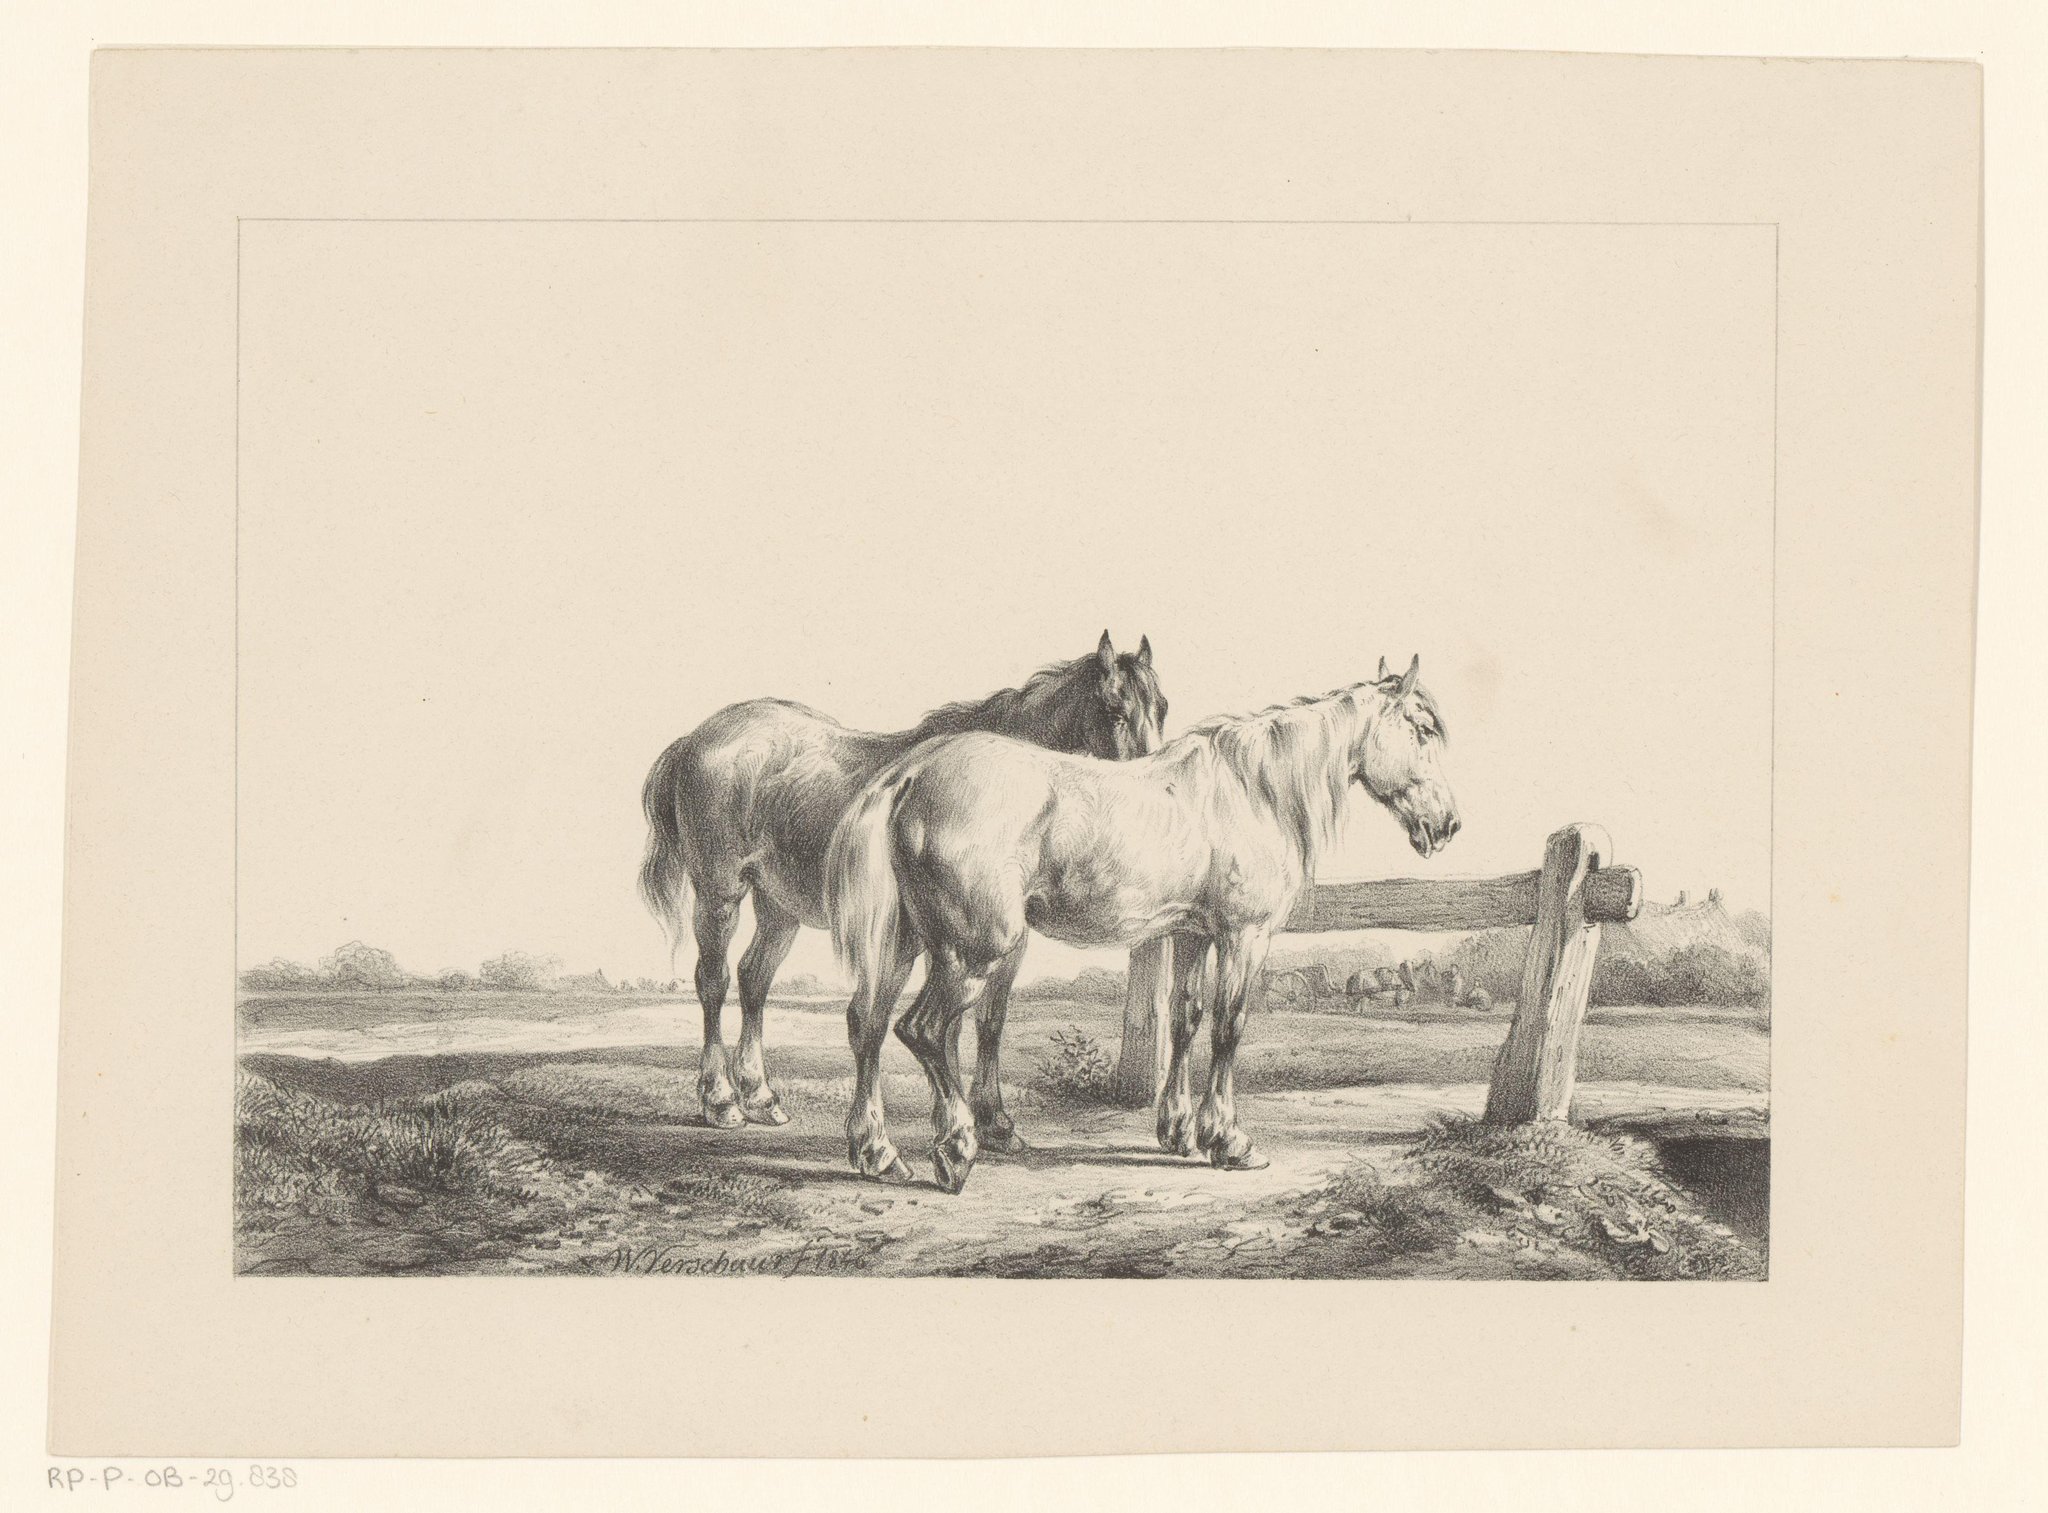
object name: print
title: Twee paarden in een wei bij een hek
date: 1848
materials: paper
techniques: lithograph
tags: horse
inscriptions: collector's mark: Lugt 2228